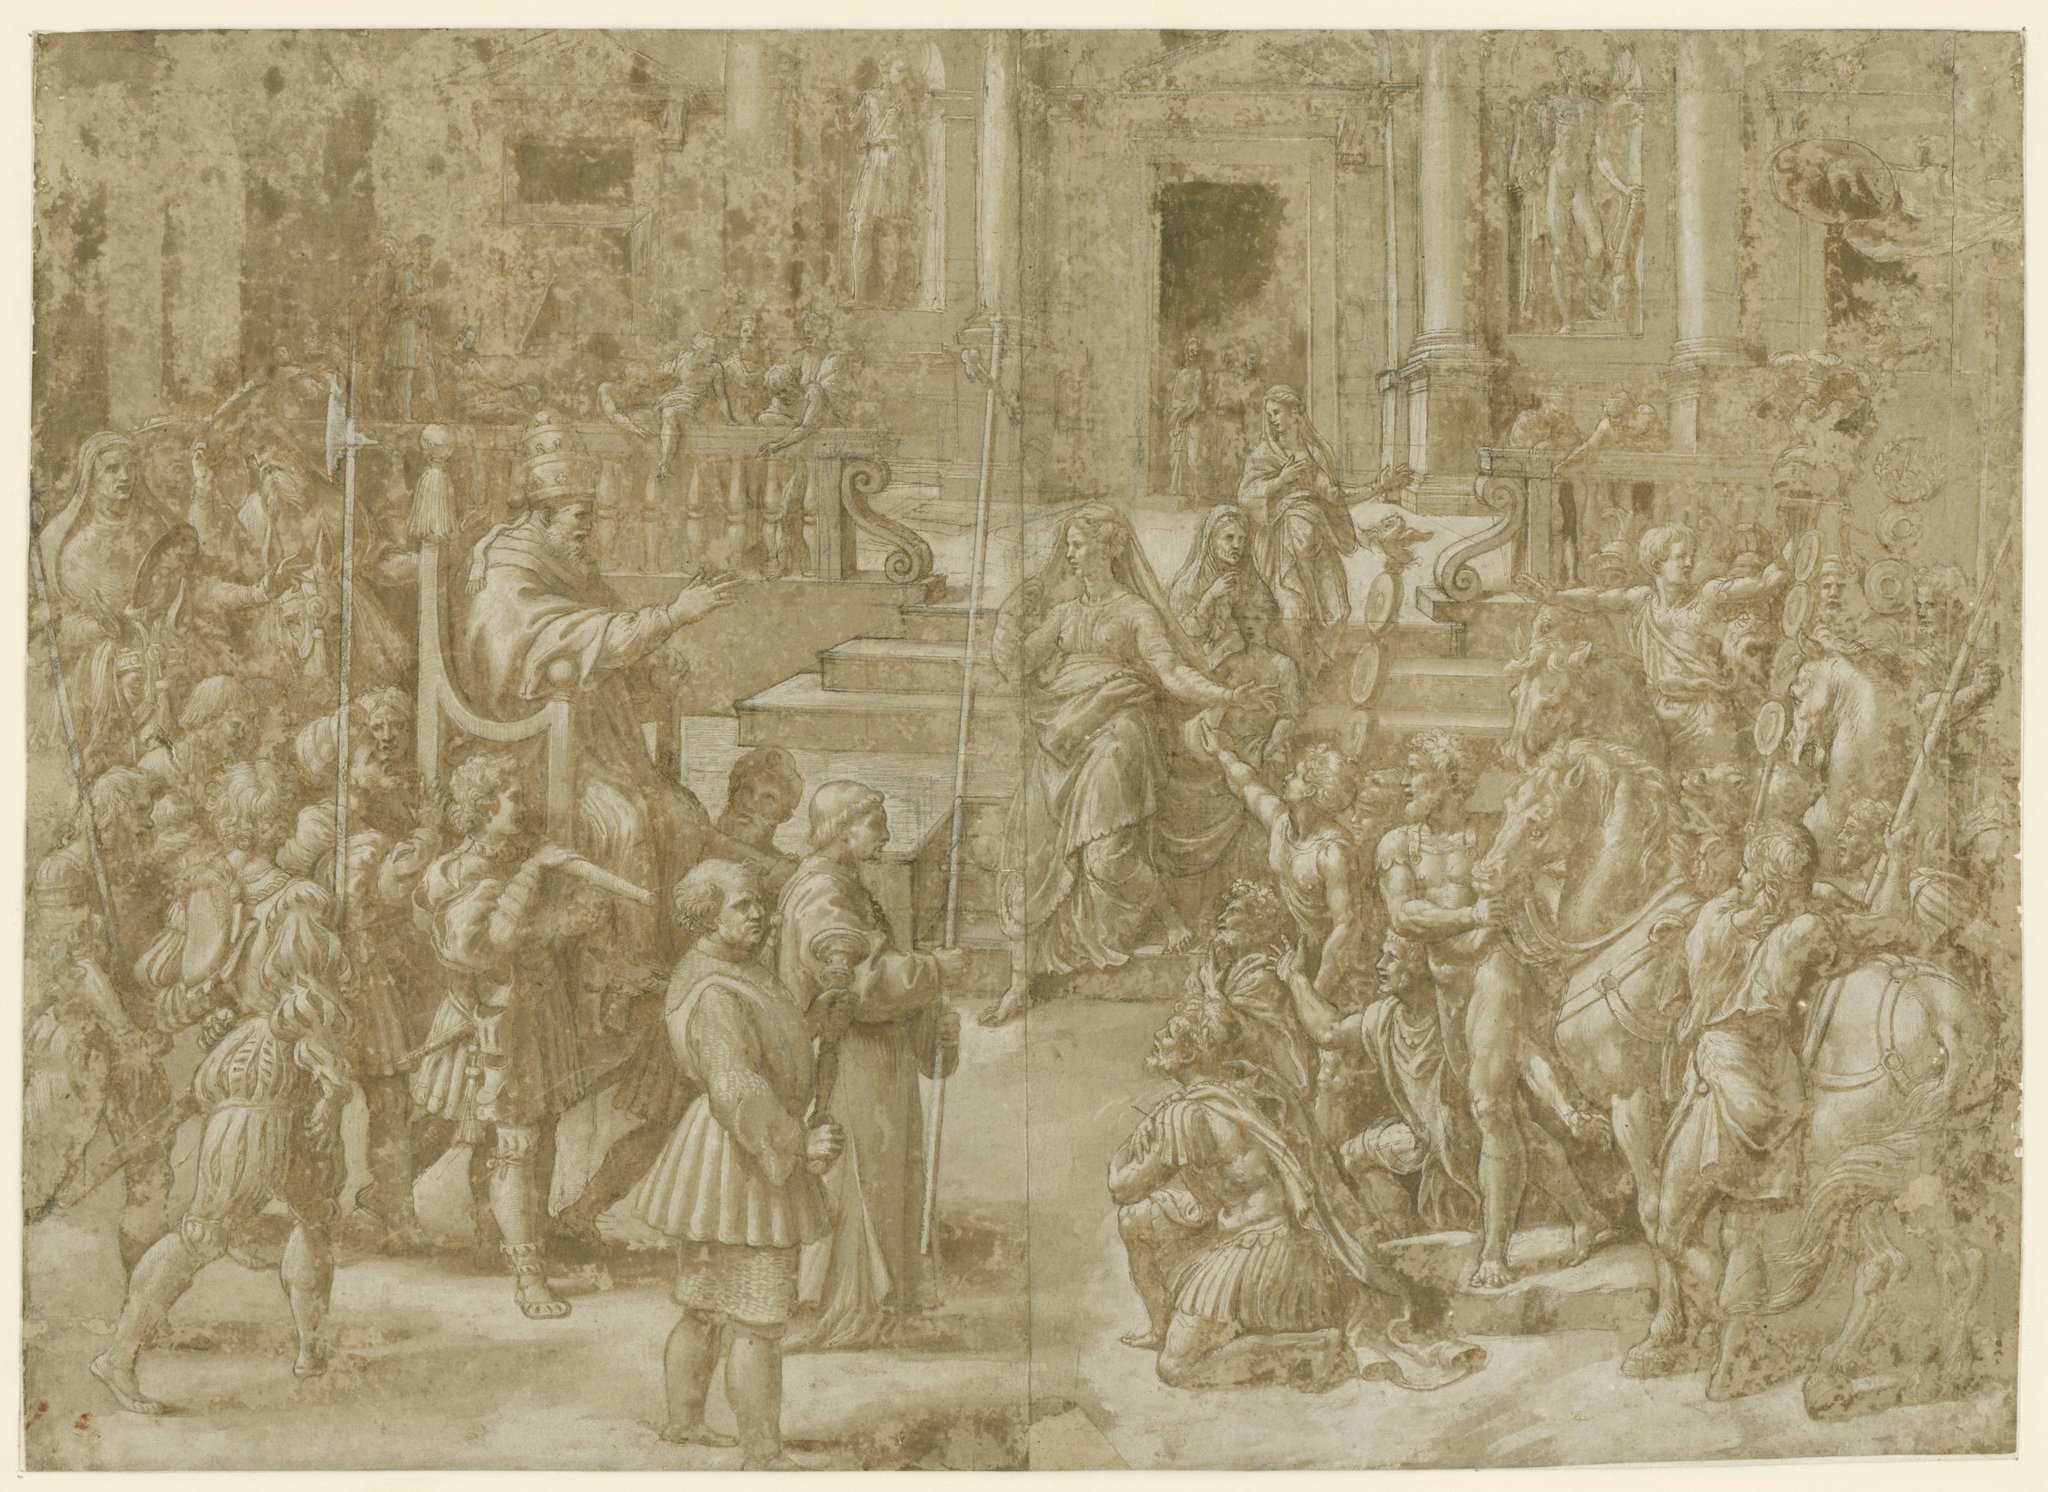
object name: drawing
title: The Donation of Constantine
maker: giulio romano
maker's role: draughtsman, painter, print maker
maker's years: 1499-1546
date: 1520-1524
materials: charcoal, ink, paper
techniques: brush, pen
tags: empress helena, mother of constantine the great; possible attributes: model of church, (royal) crown, crown of thorns, cross, three nails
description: Giulio Romano was praised for his original and inventive drawn designs for frescoes (wall paintings), which were subsequently executed by assistants. This is such a modello, a highly detailed design for a fresco in the Vatican made between 1520-1524. It depicts Emperor Constantine transferring the secular authority over Rome to Pope Sylvester I.